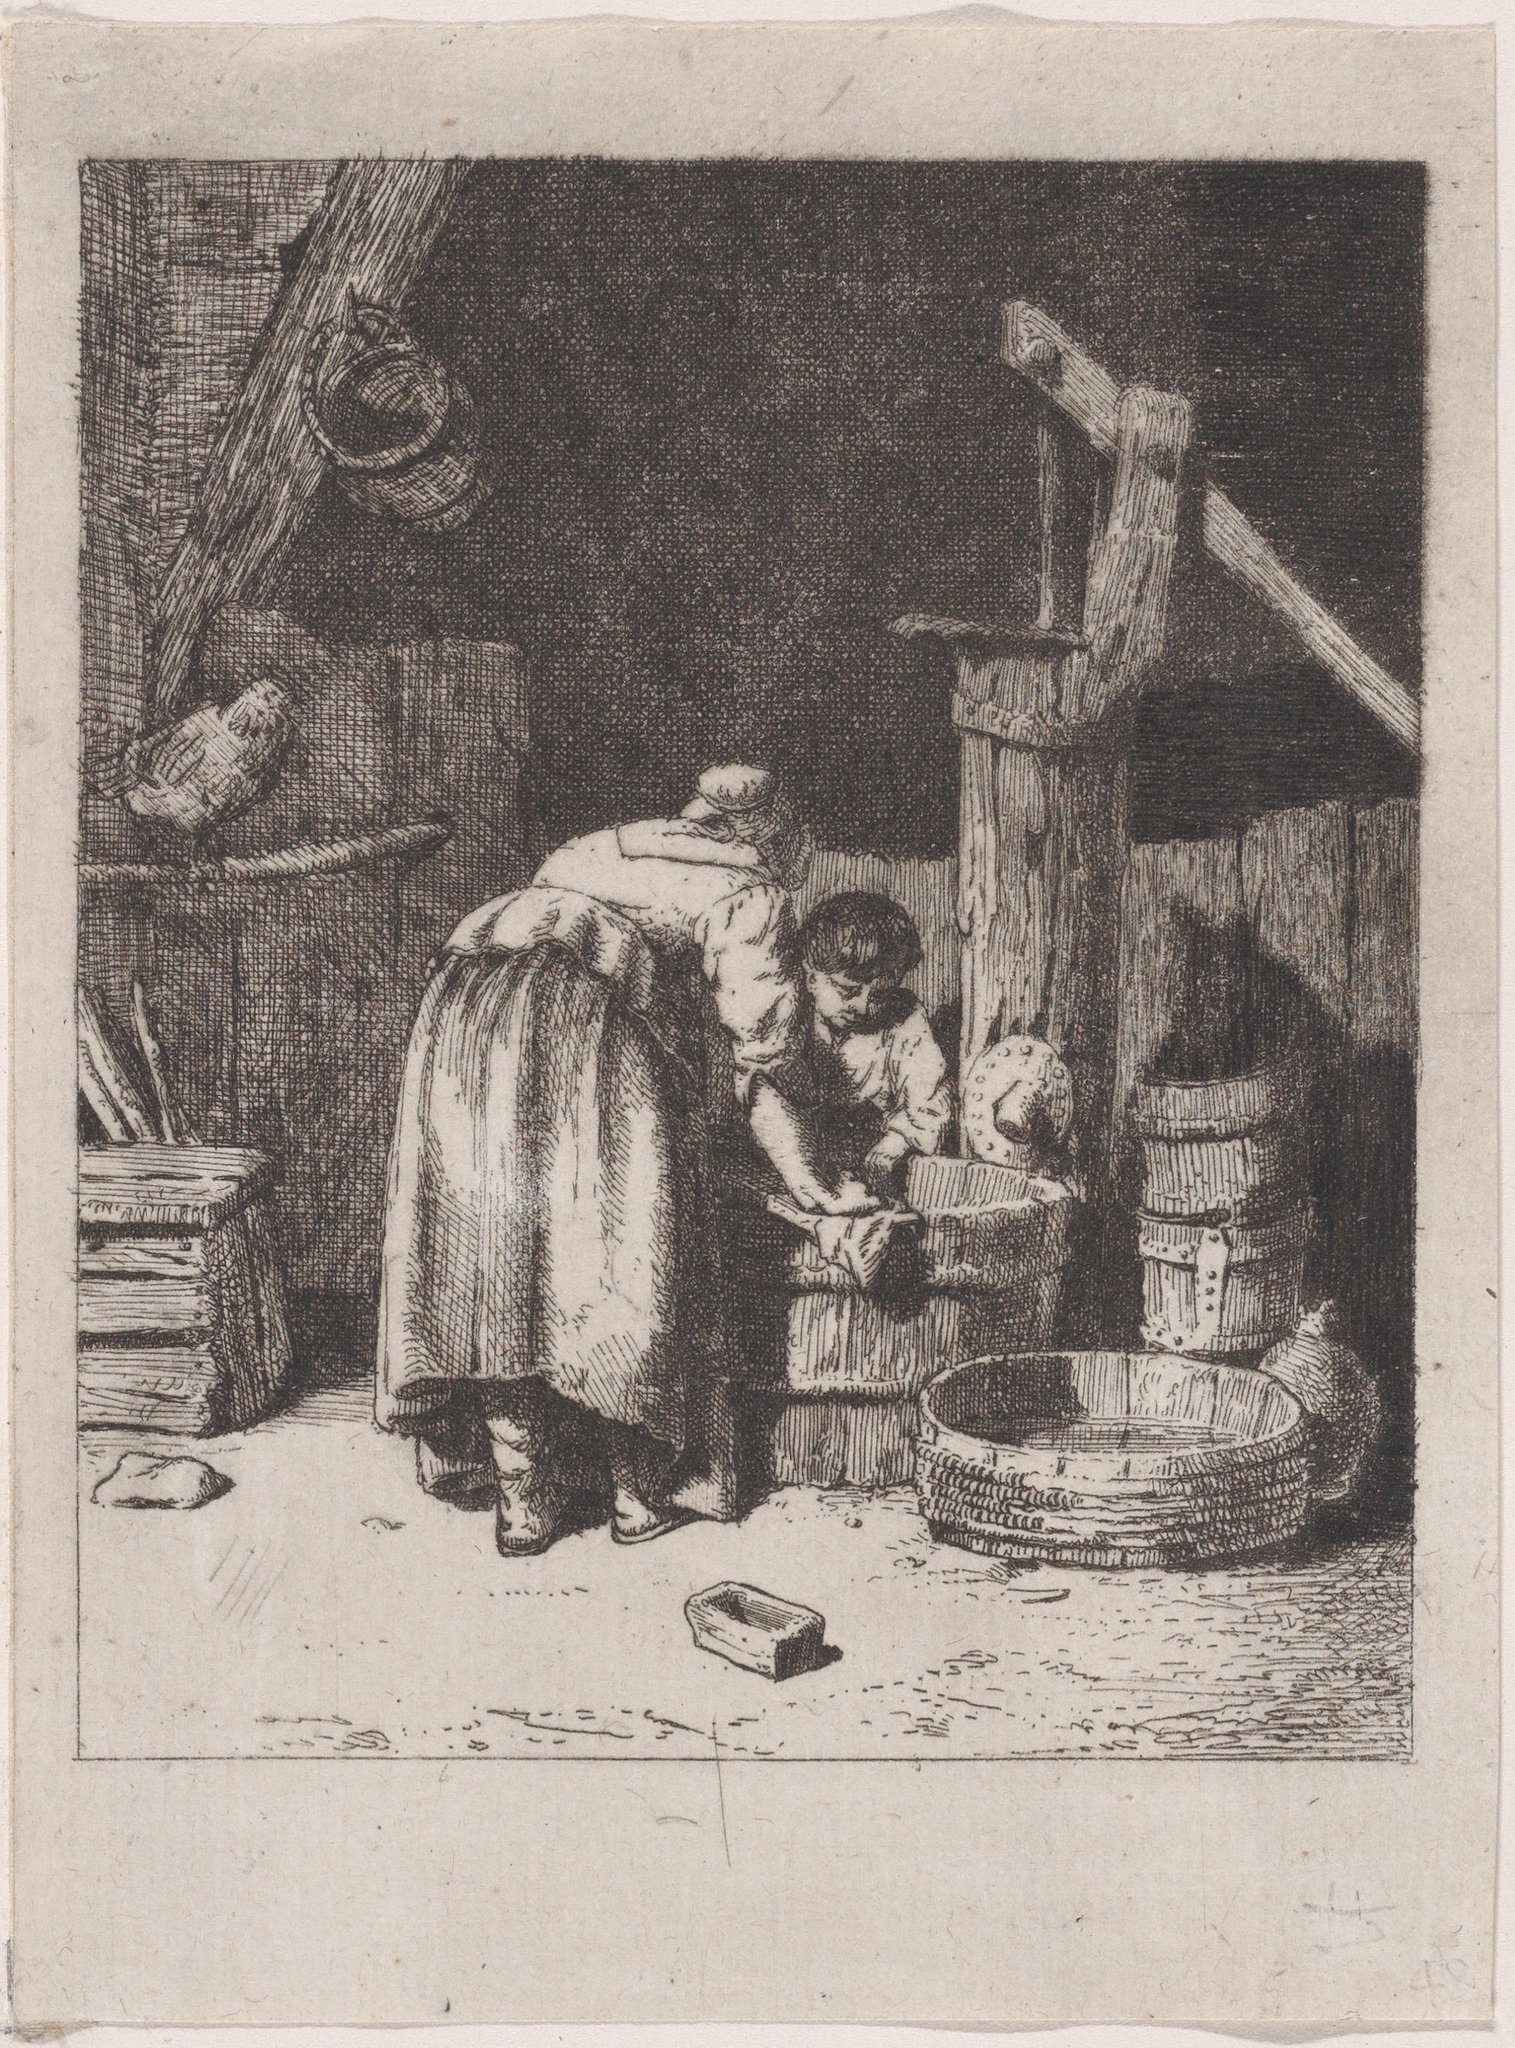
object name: print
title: Women Washing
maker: charles émile jacque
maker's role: artist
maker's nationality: french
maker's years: 1813-1894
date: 1845-1850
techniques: etching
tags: women,washing